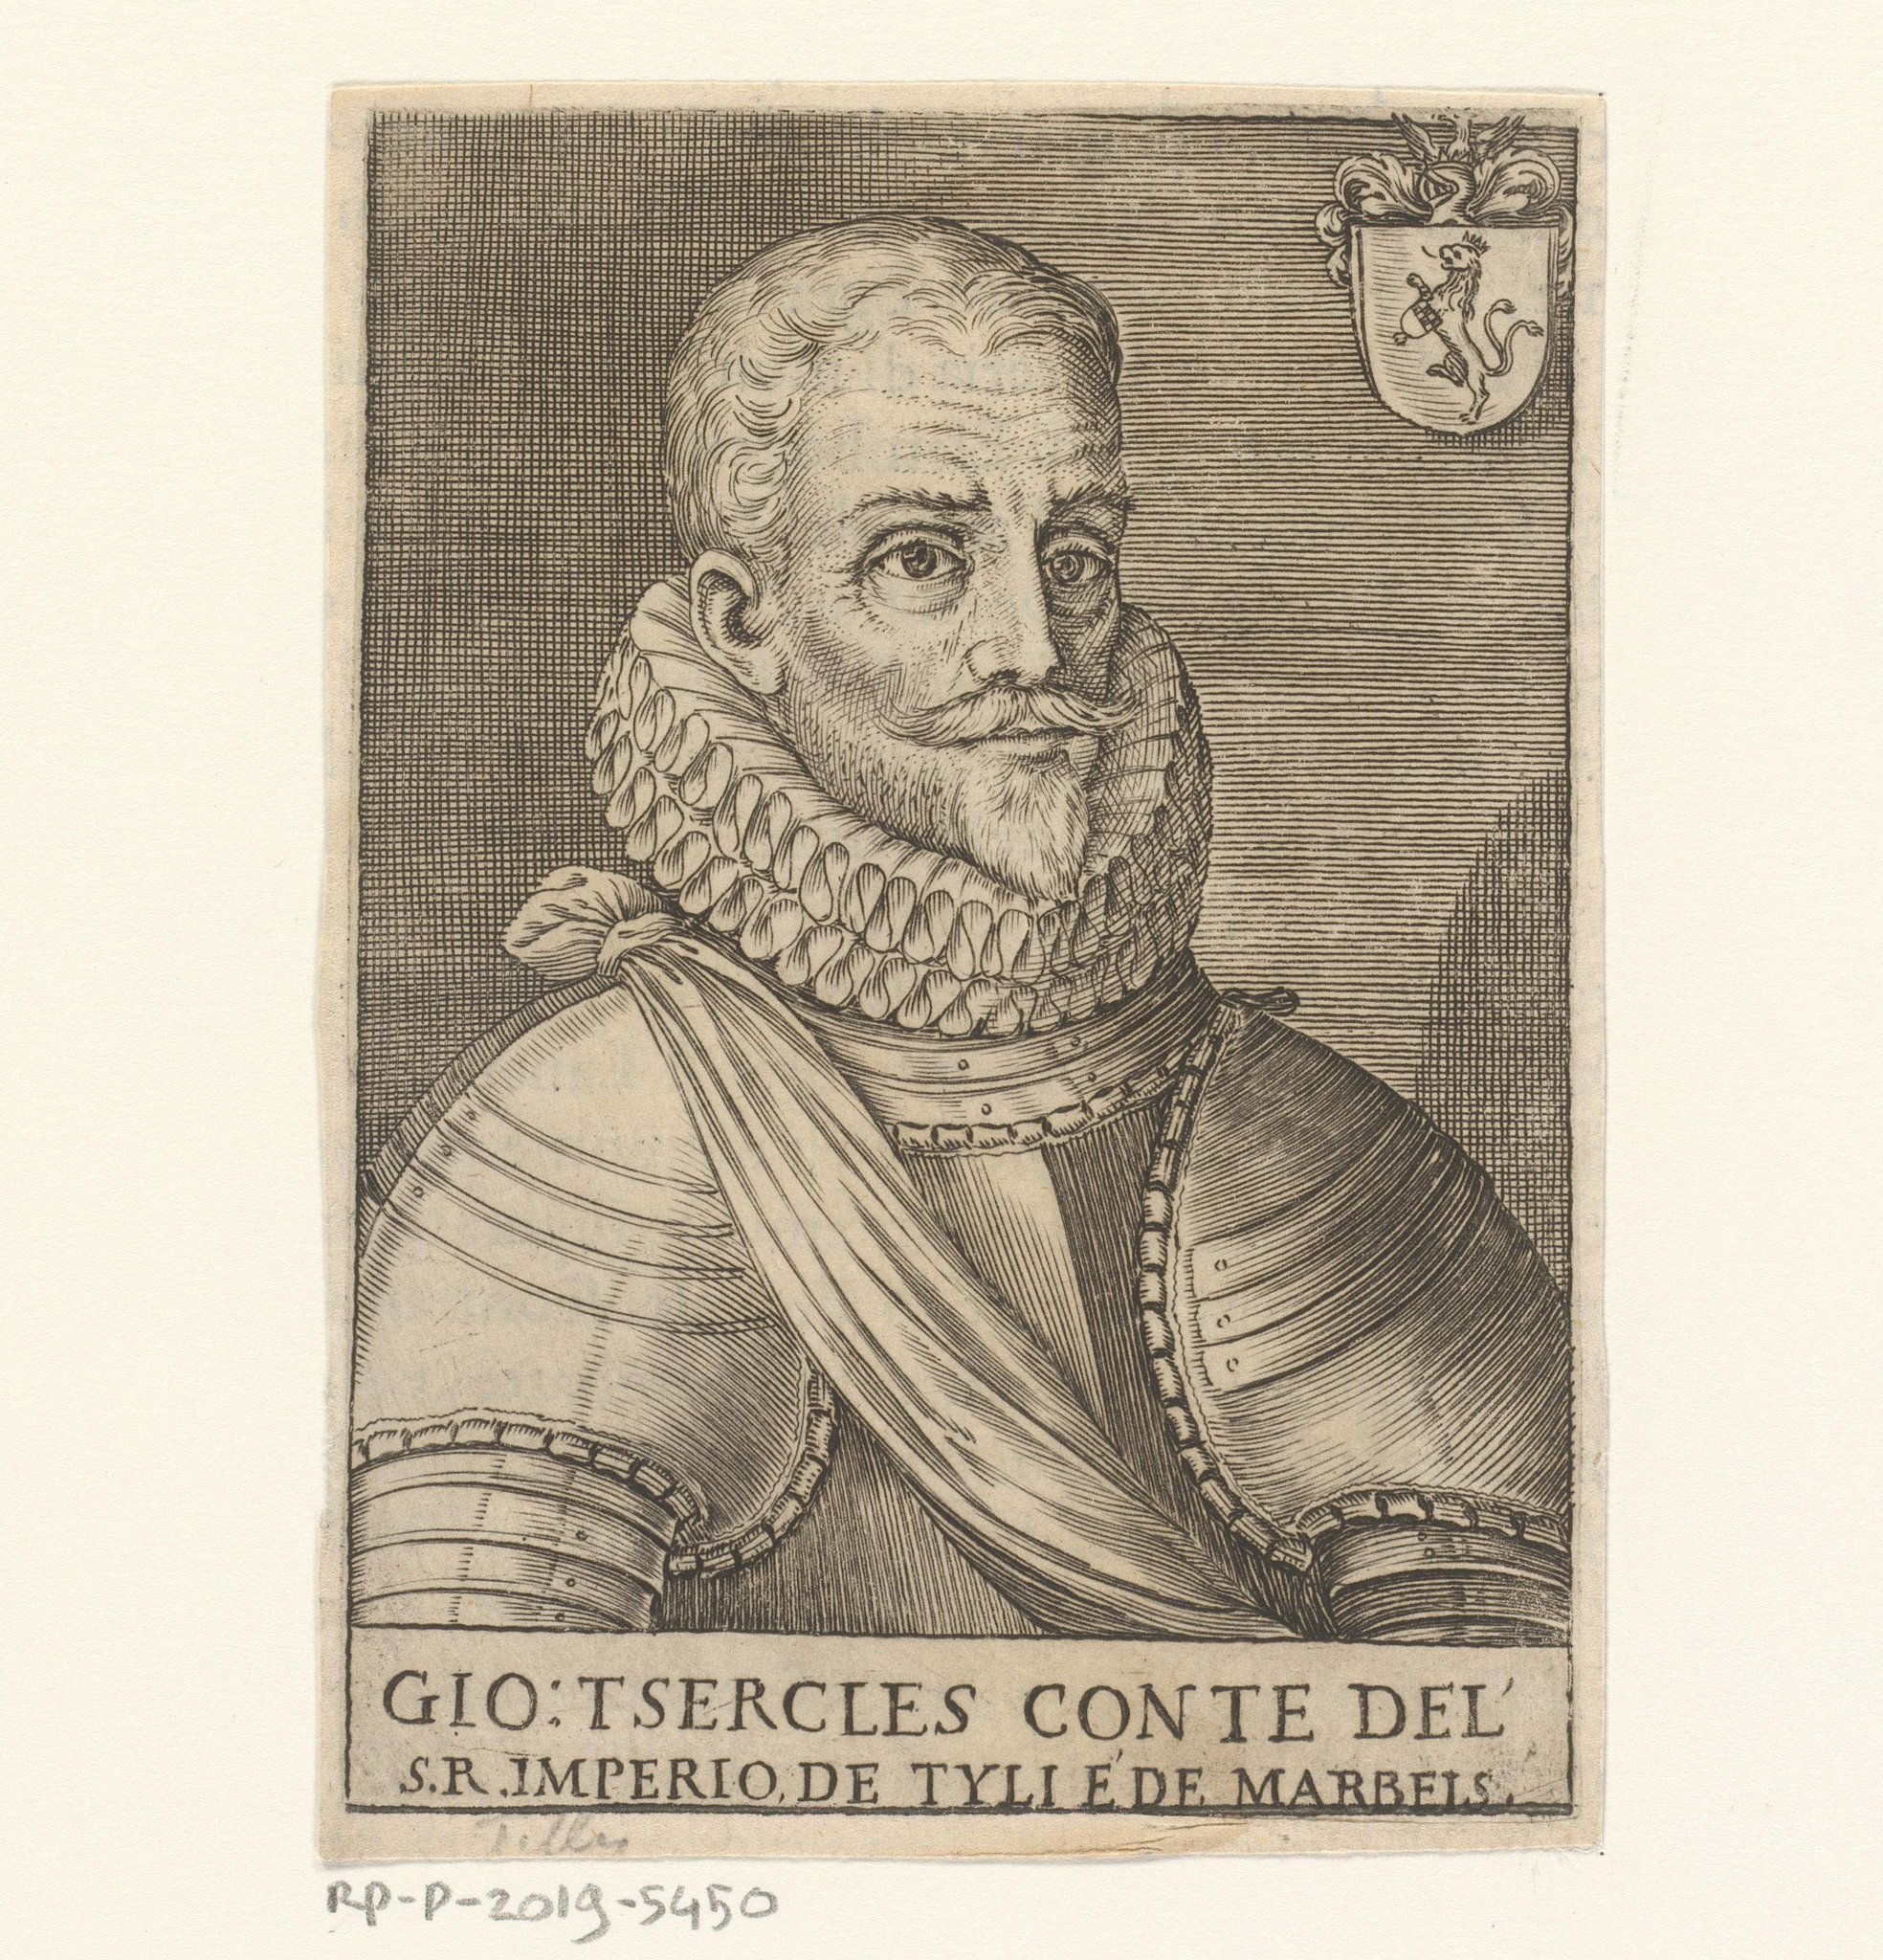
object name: print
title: Portret van Johan 't Serclaes, graaf van Tilly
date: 1646-1647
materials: paper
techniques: engraving, letterpress printing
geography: rome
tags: ranks in the army, historical persons, armorial bearing, heraldry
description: Prent uit: Ritratti et elogii di capitani Illustri. Che ne'secoli moderni hanno gloriosamente guerreggiato. Rome: Filippo de'Rossi en Vitale Mascardi, 1646, p. 371. Prent ook gebruikt in dezelfde editie van 1647. Eerdere staat van prent in ieder geval ook gebruikt in: Ritratti et elogii di capitani Illustri. Rome: Pompilio Totti en Andrea Fei, 1635.